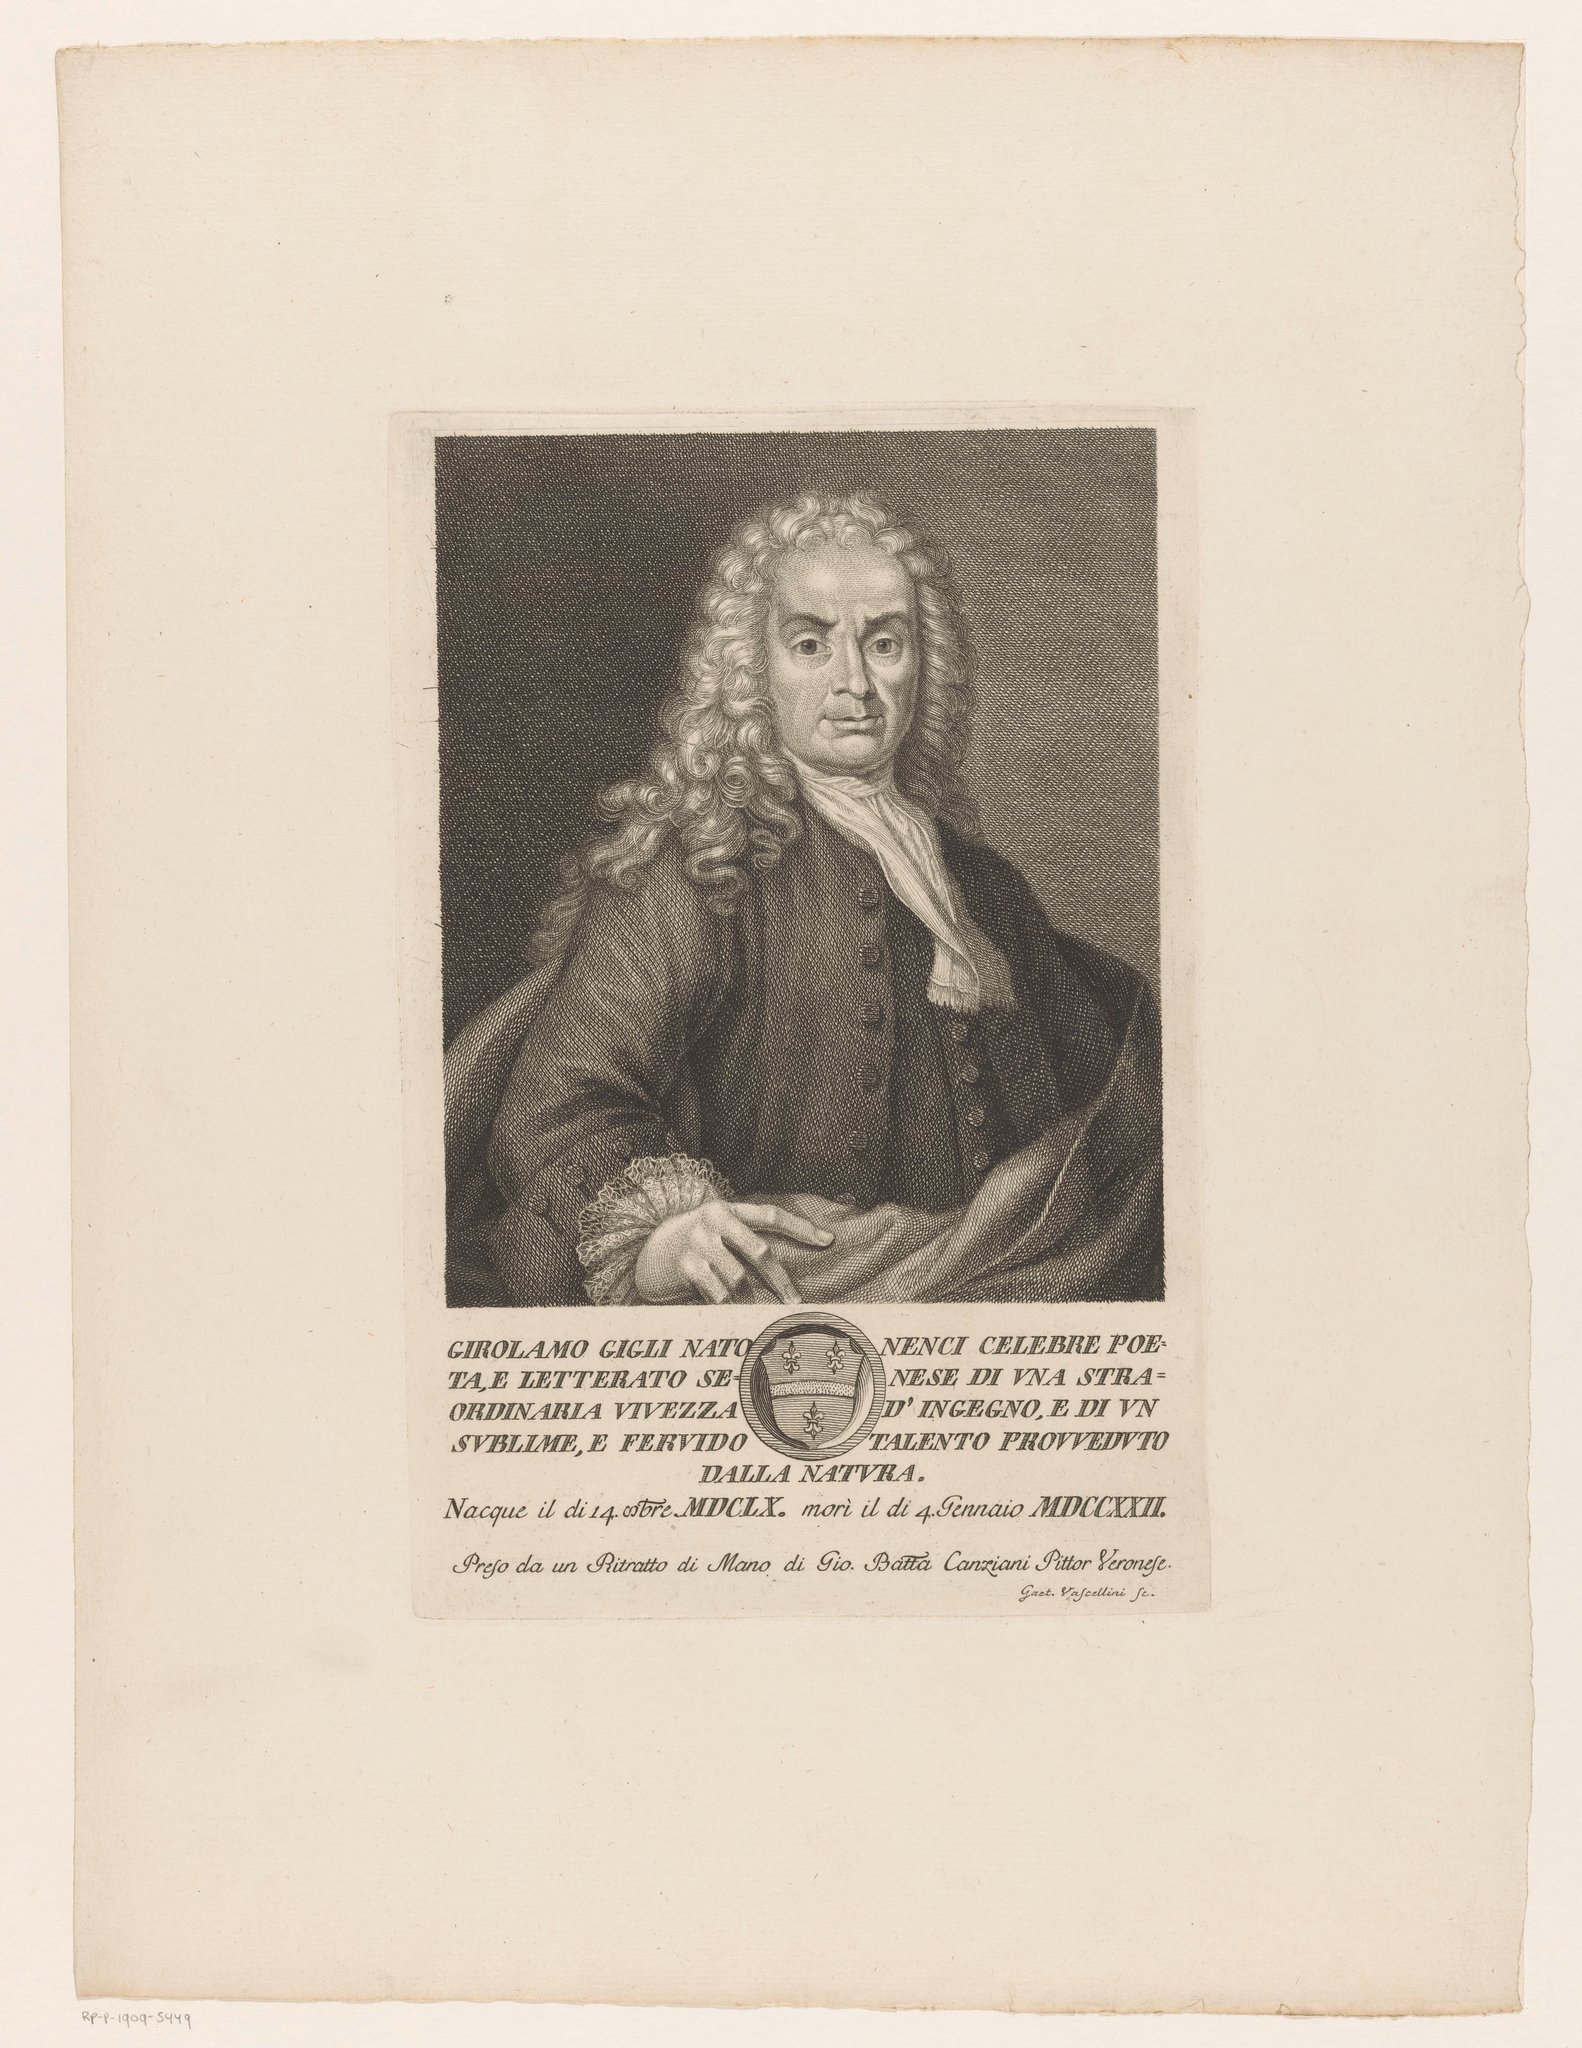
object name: print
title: Portret van schrijver Girolamo Gigli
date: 1755-1805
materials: paper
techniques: engraving, etching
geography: italy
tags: rome, historical persons, portrait of a writer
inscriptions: collector's mark: Lugt 2228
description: Onder het portret een tekst in het Italiaans en een wapenschild in een cirkelvormig kader.